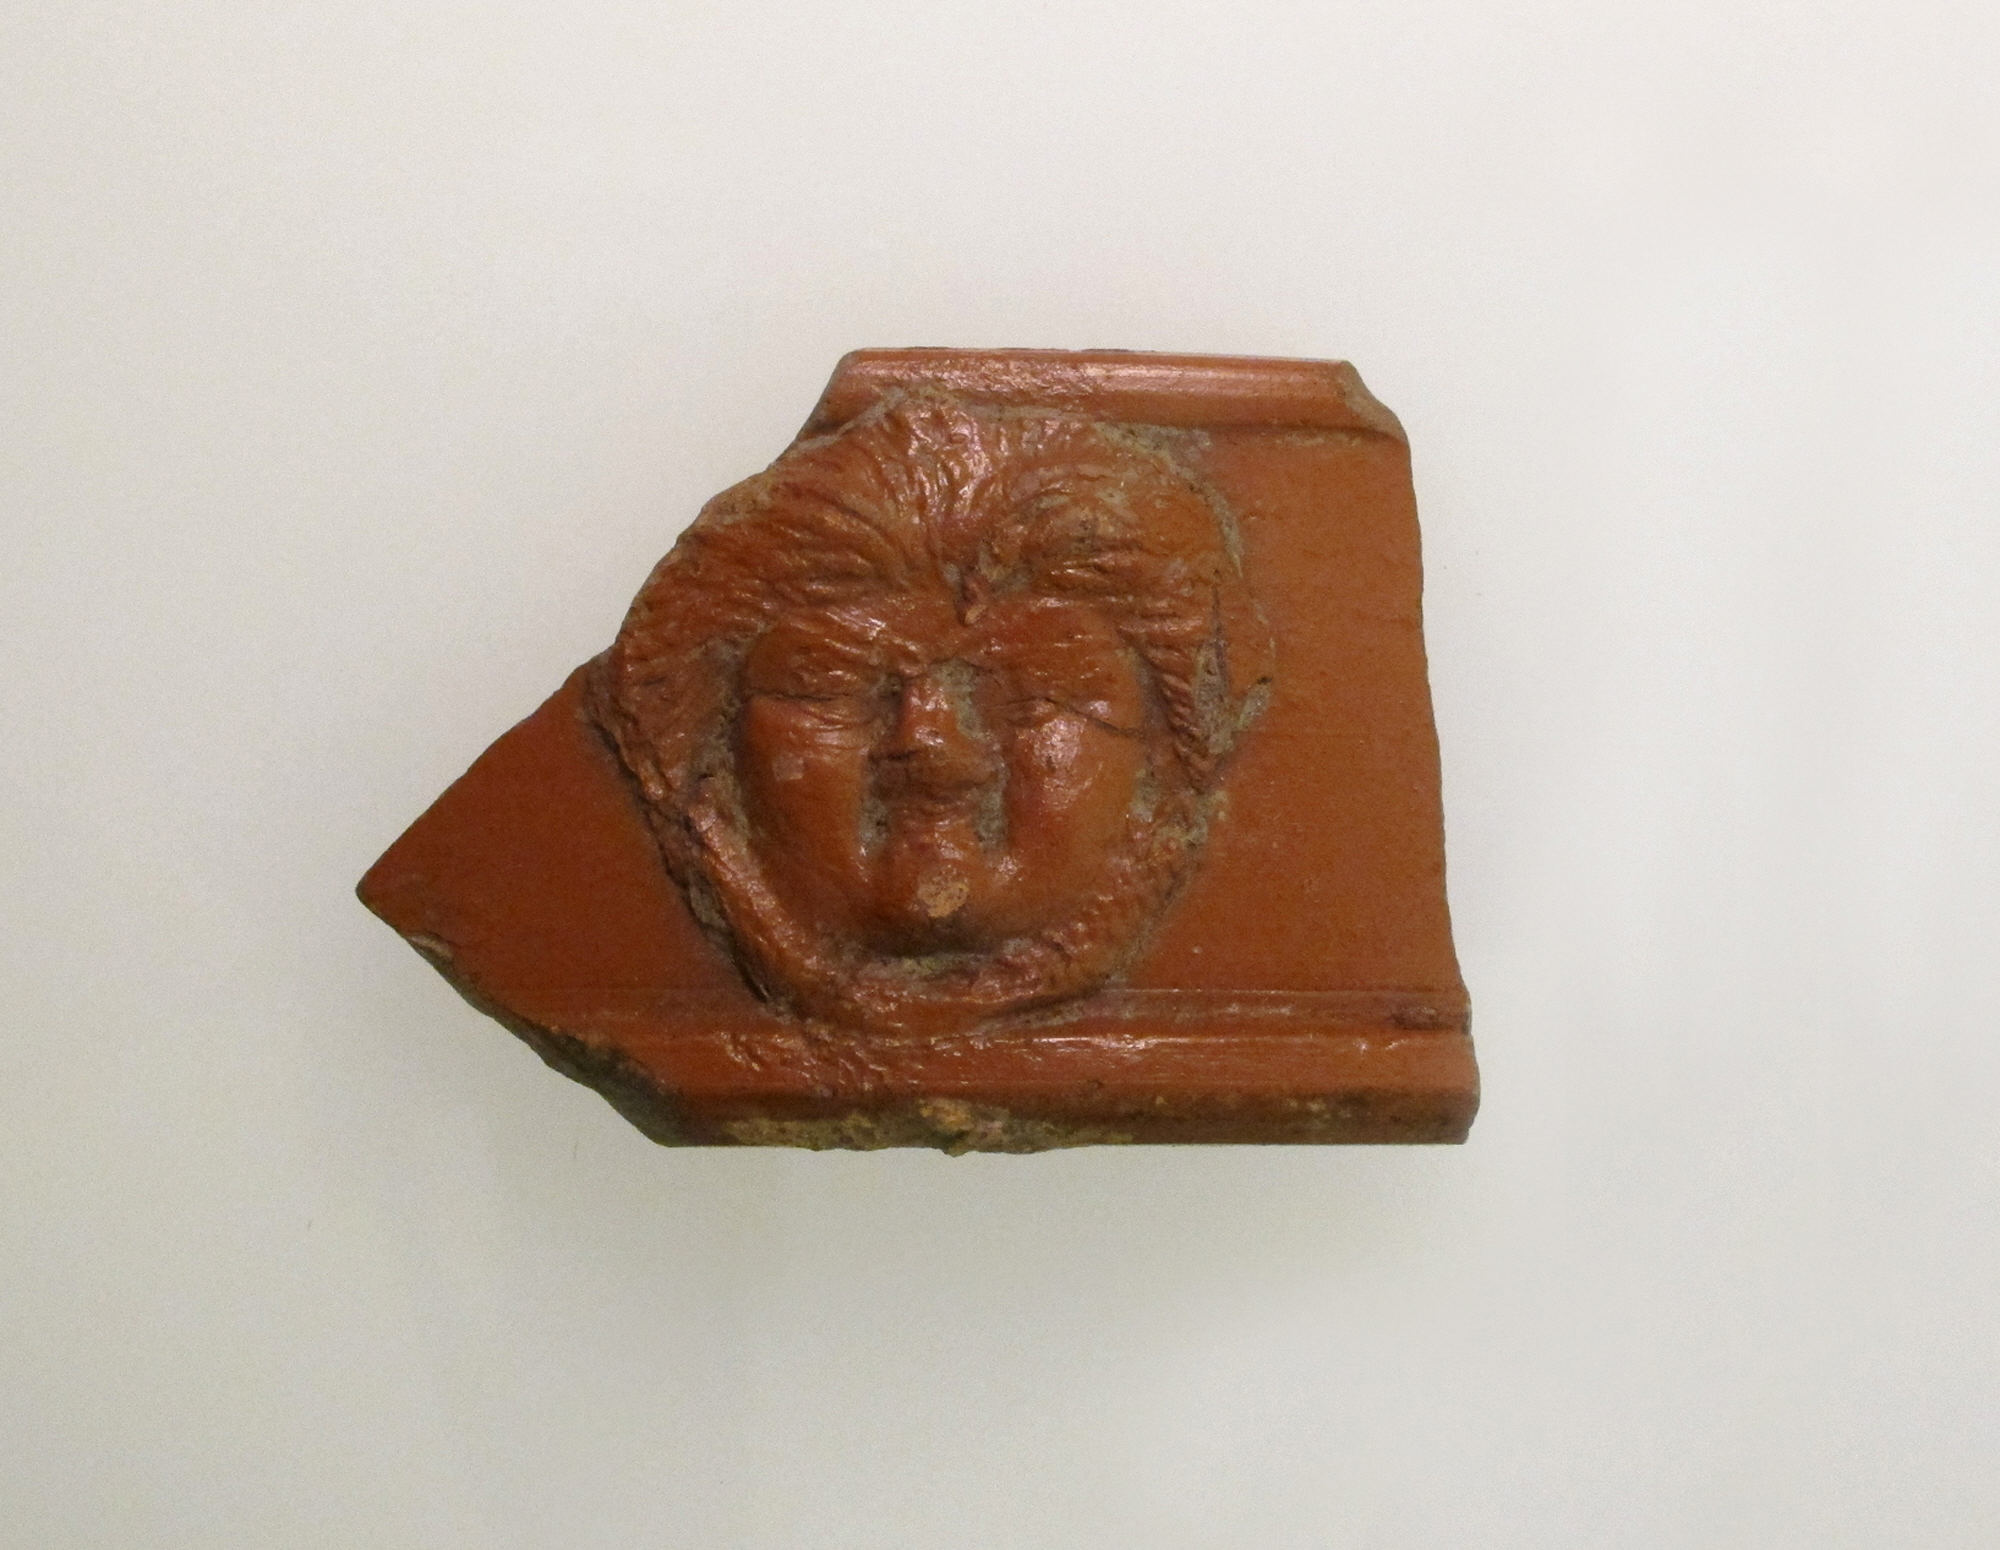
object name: vase fragment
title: Arretine ware fragment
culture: roman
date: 670 BCE-330 CE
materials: terracotta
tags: faces